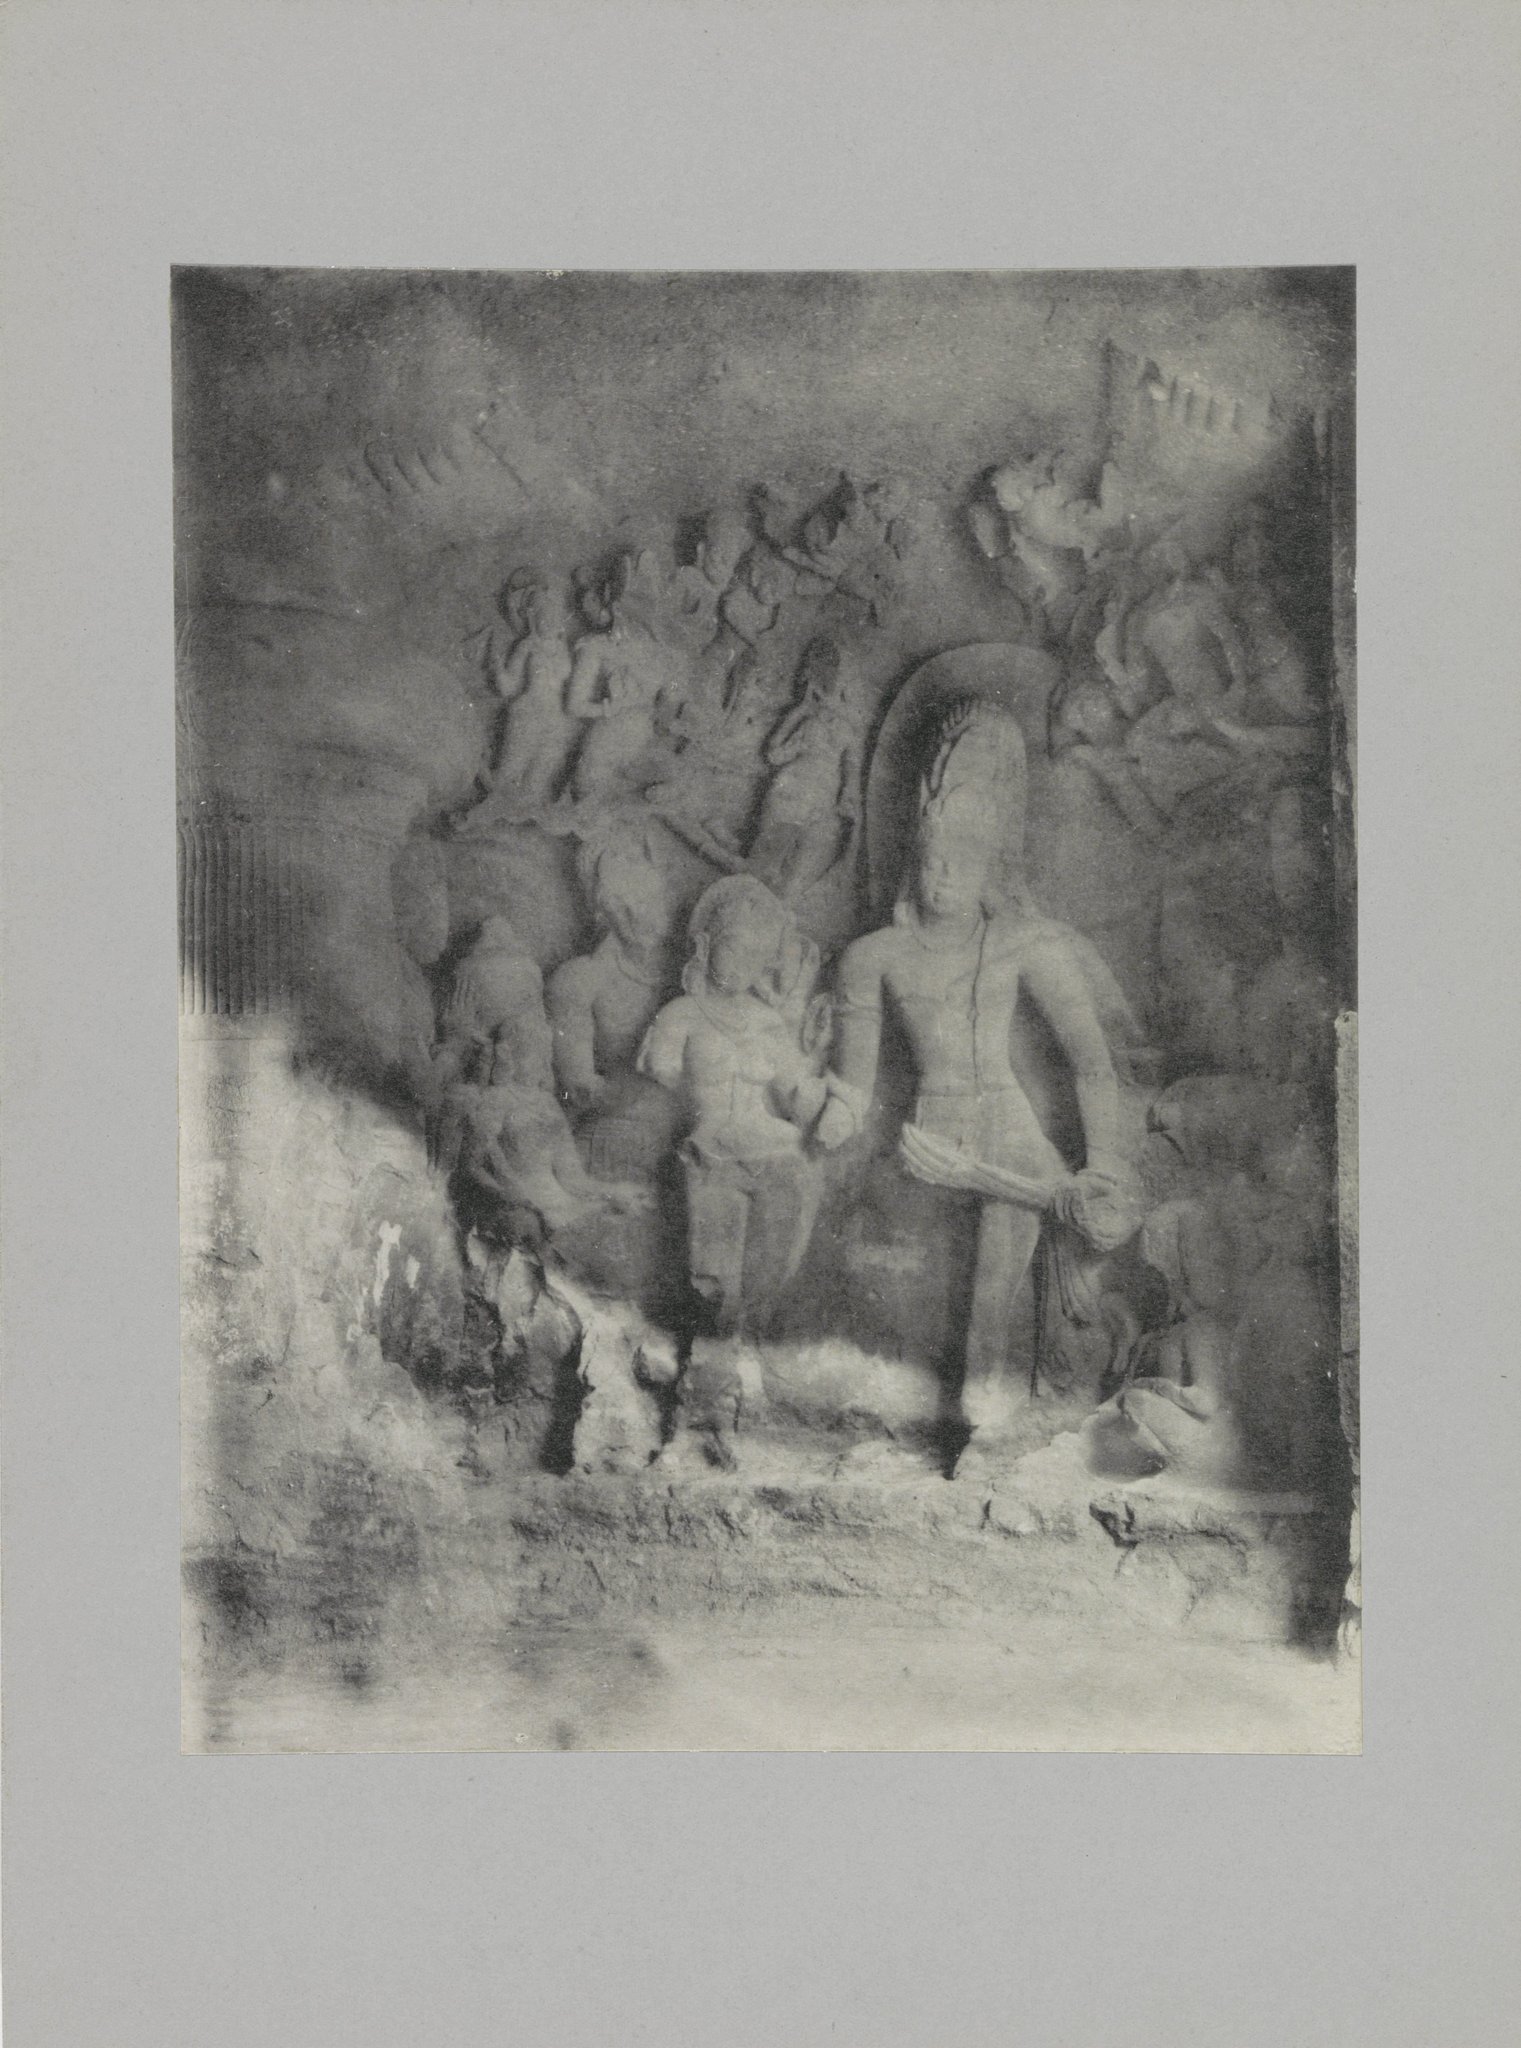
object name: photomechanical print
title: Relief in Elephanta Caves near Mumbai, Maharashtra, India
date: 1895-1915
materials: cardboard, paper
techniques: photograph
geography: mumbai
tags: mumbai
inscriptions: annotation: ‘72. Elefanta.’